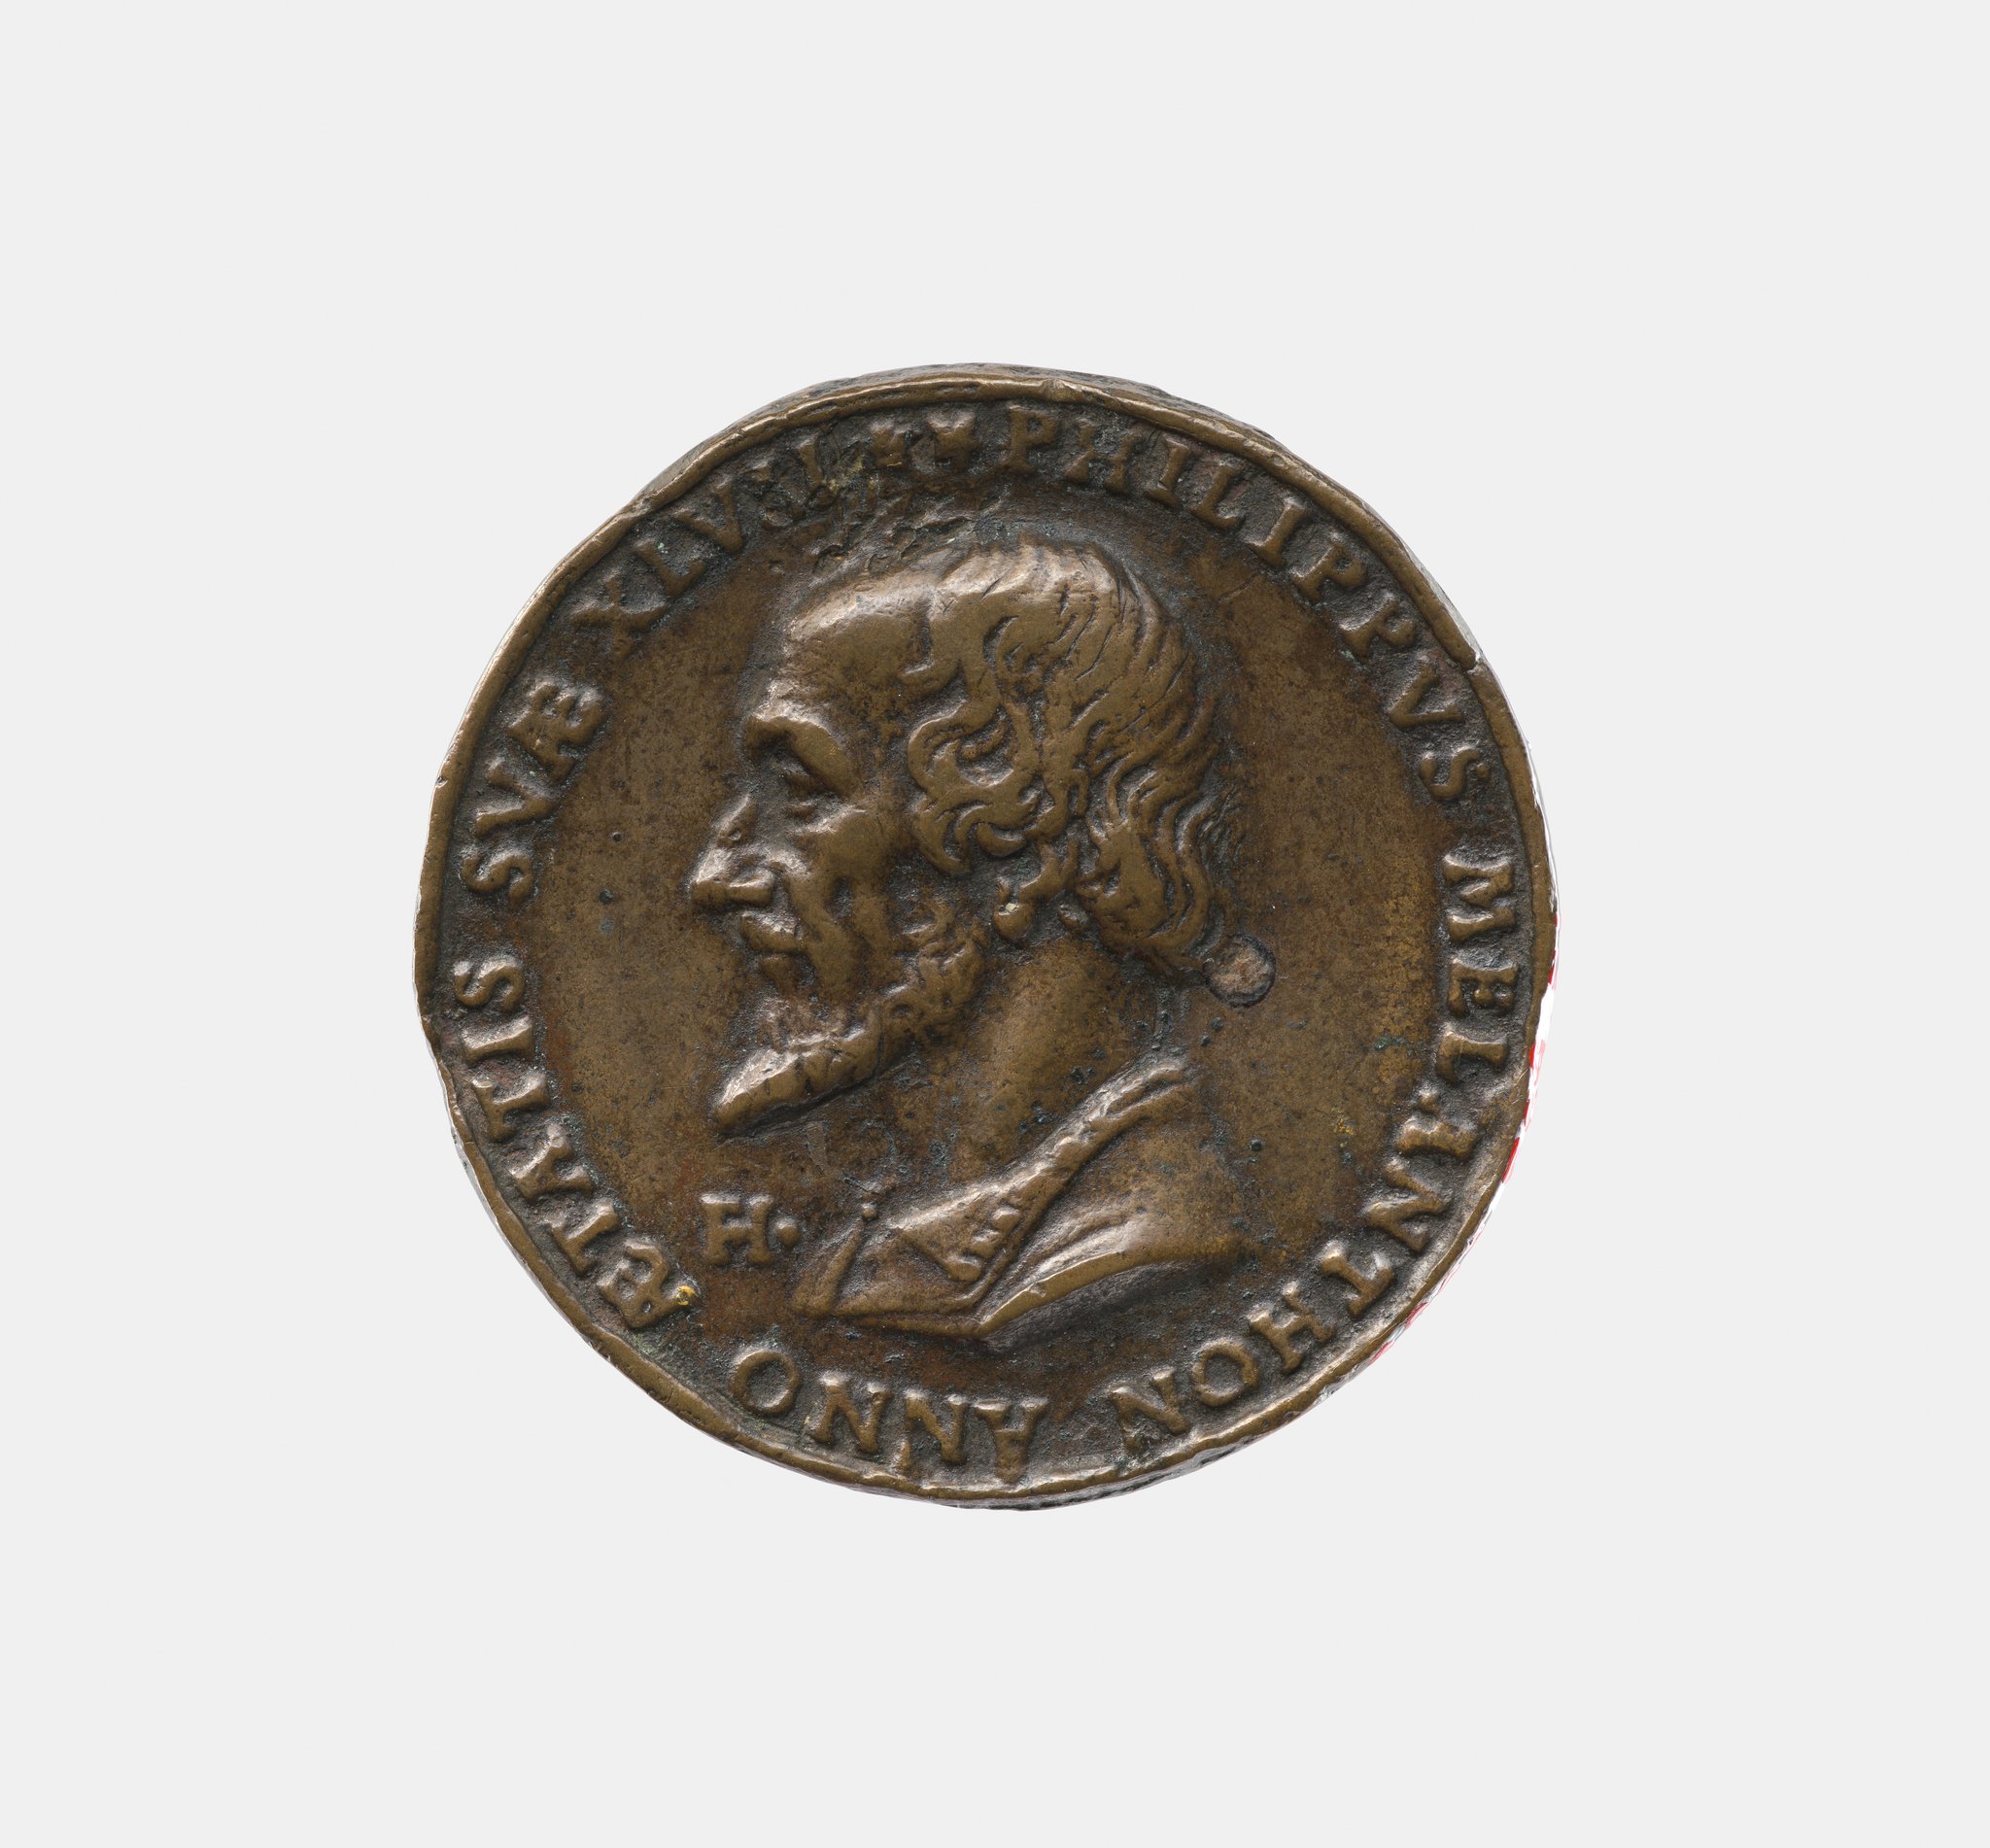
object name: medal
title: Philipp Melanchthon 1497-1560, Reformation leader and humanist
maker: friedrich hagenauer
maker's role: artist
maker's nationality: german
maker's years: 1490-1546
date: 1543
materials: bronze